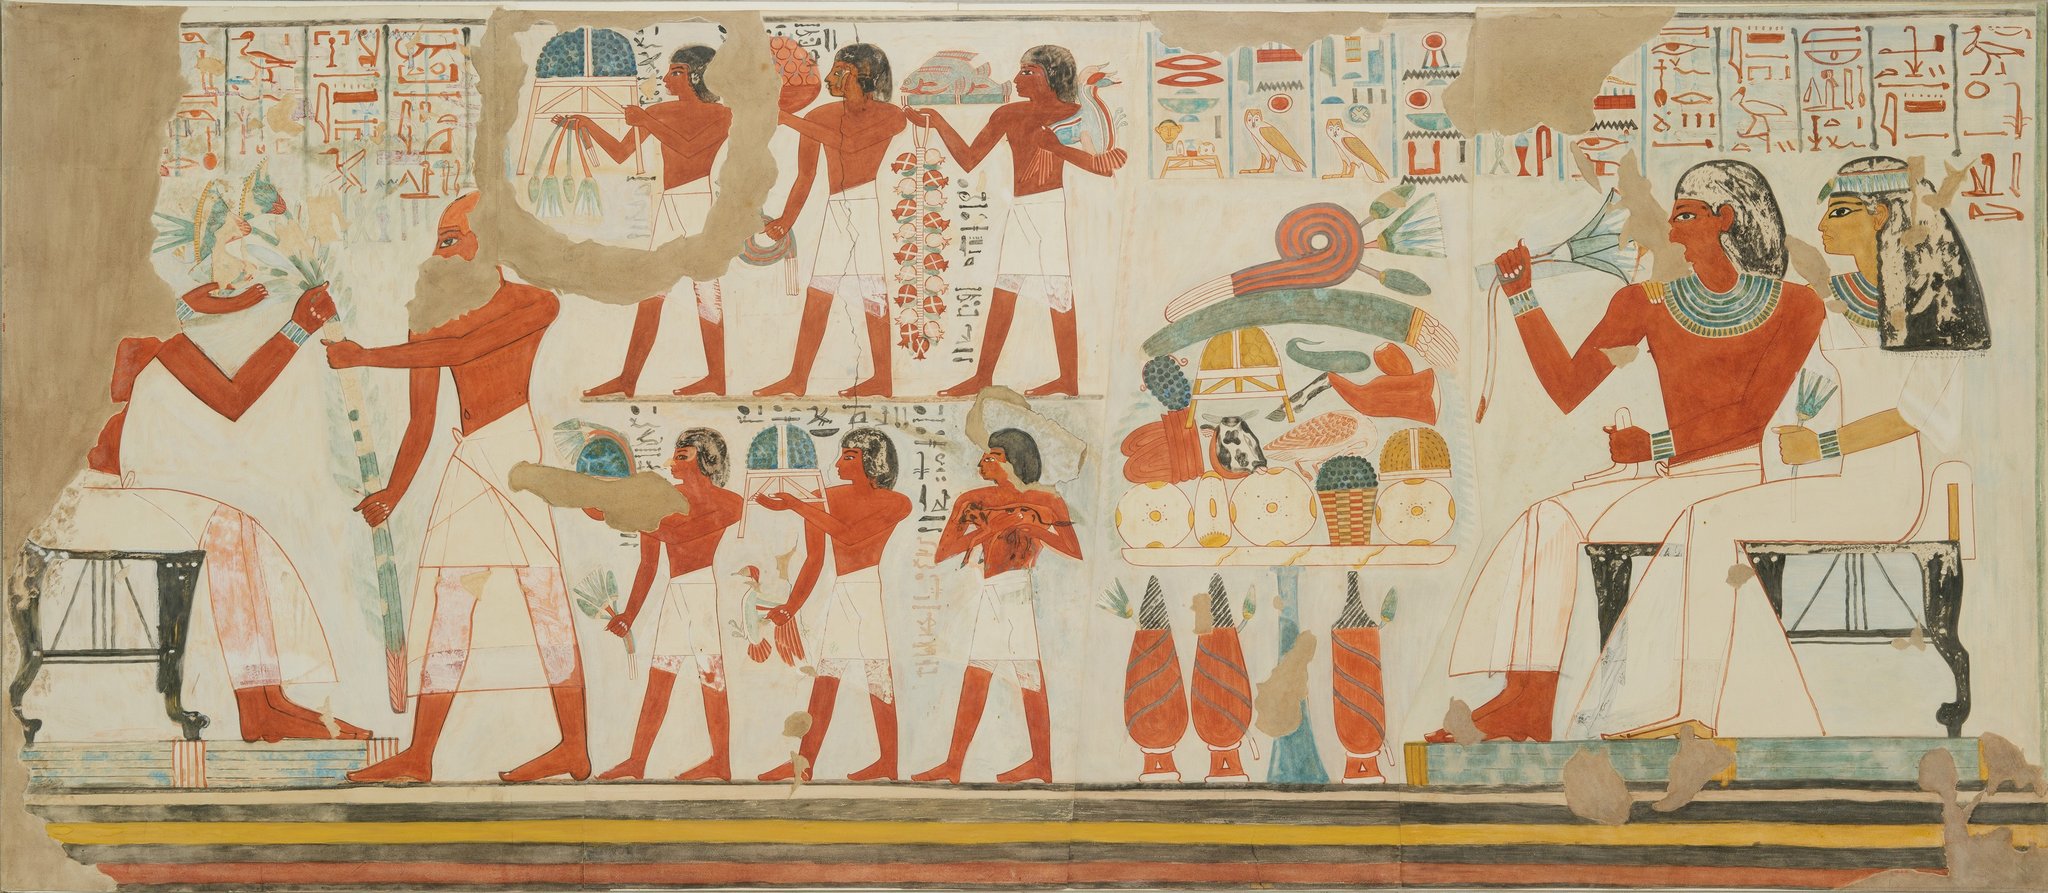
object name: facsimile, djehuty tt 45, offering scene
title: Offerings Made to the Deceased and his Wife, Tomb of Djehutyemheb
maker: norman de garis davies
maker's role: artist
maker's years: 1865-1941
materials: paper, paint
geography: egypt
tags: men,women,hieroglyphs